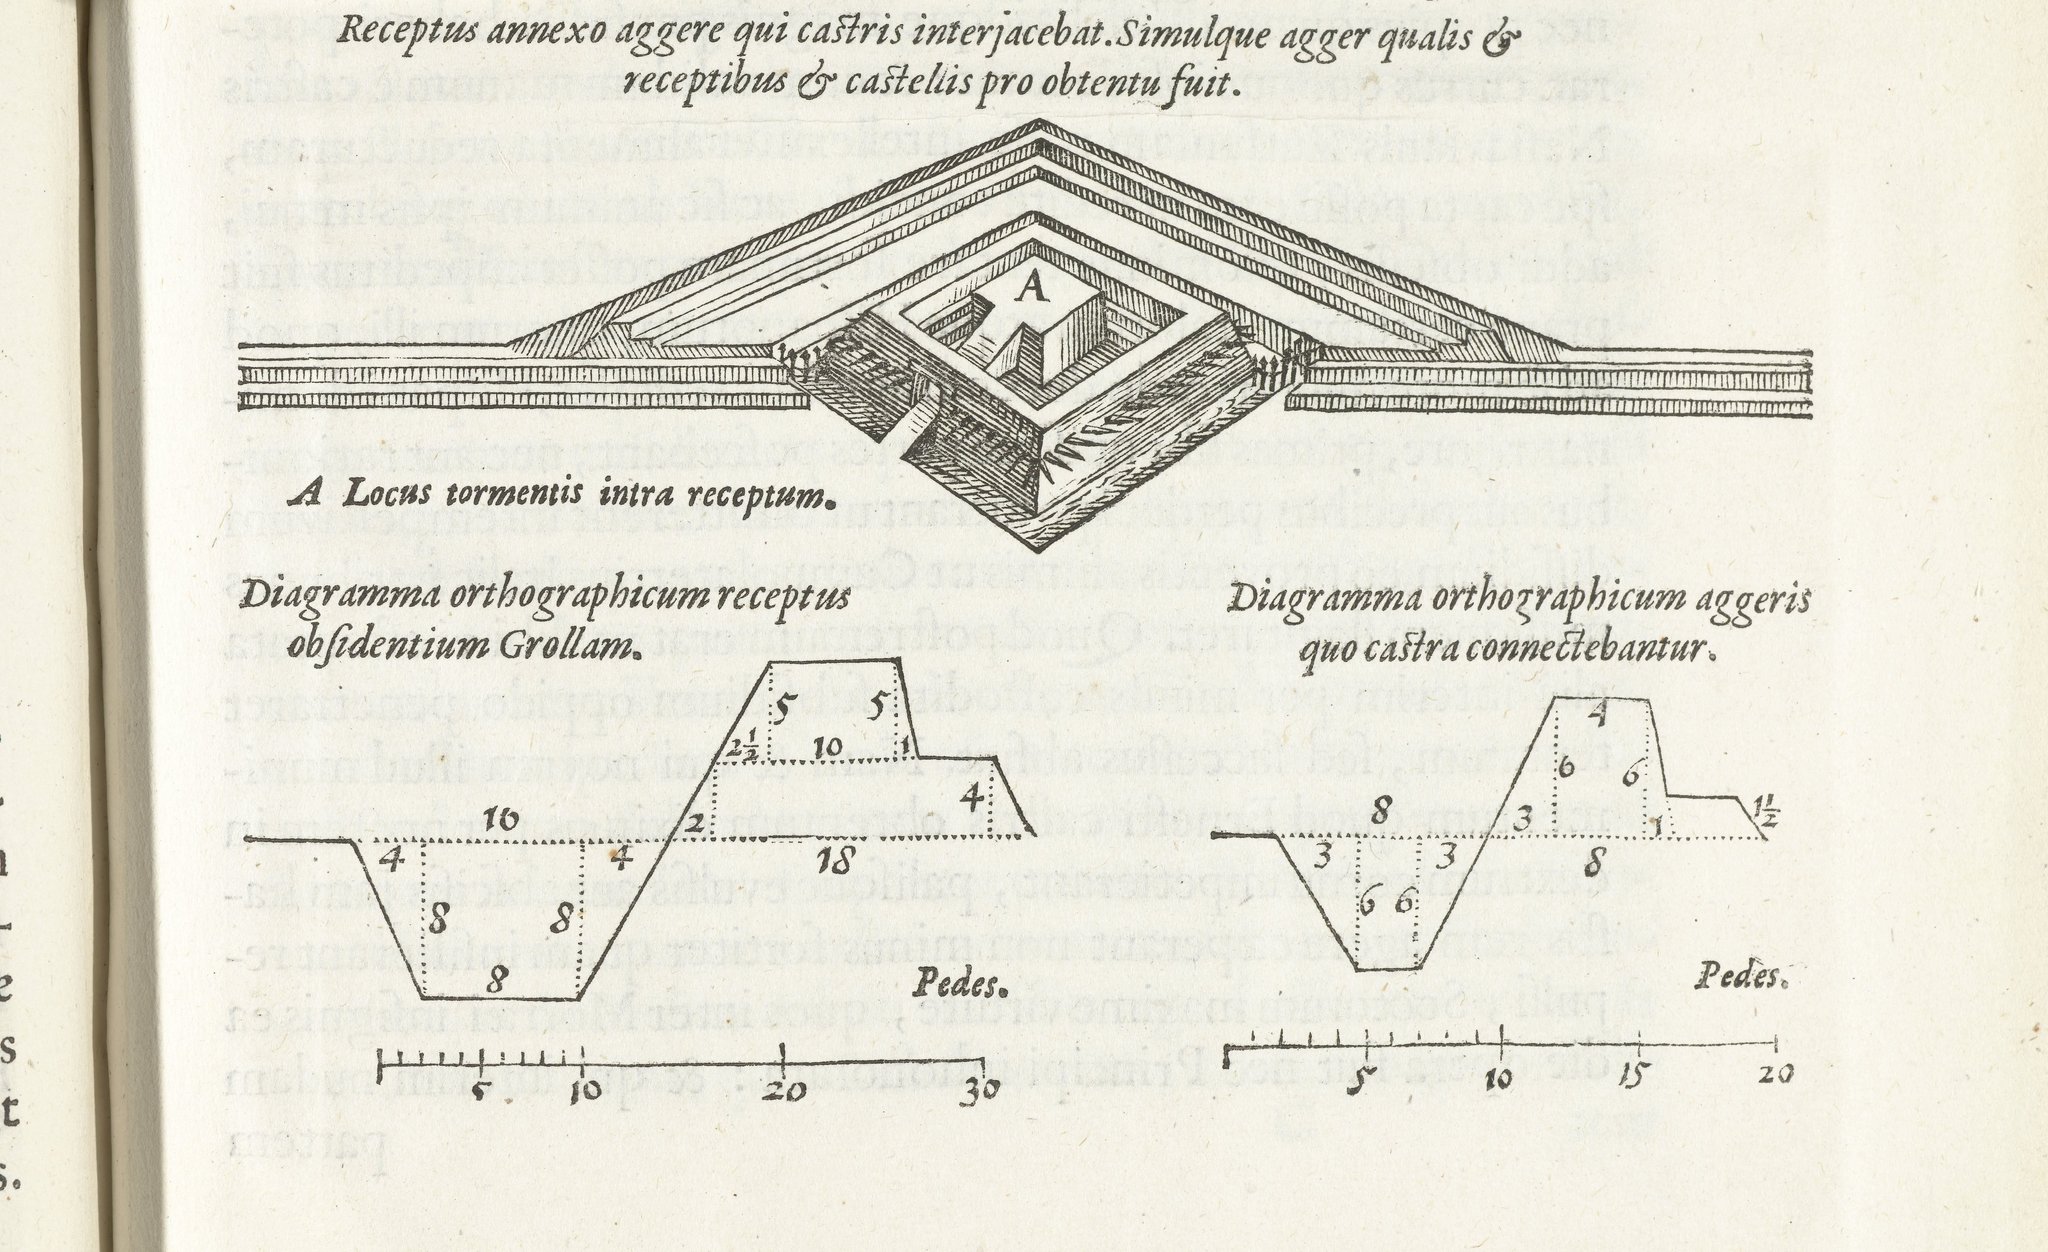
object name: print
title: Bastion met twee doorsneden tijdens het beleg van Bergen op Zoom, 1622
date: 1627-1629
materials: paper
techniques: woodcut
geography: northern netherlands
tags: fortress, bergen op zoom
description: Tekstillustratie met een bastion met twee doorsneden tijdens het mislukte beleg van Bergen op Zoom door het Spaanse leger onder Spinola en Velasco, 18 juli - 3 oktober 1622. Onderdeel van de platen bij het verslag van het beleg en de verovering van Grol door het Staatse Leger onder Frederik Hendrik, 6 juli tot 19 augustus 1627.